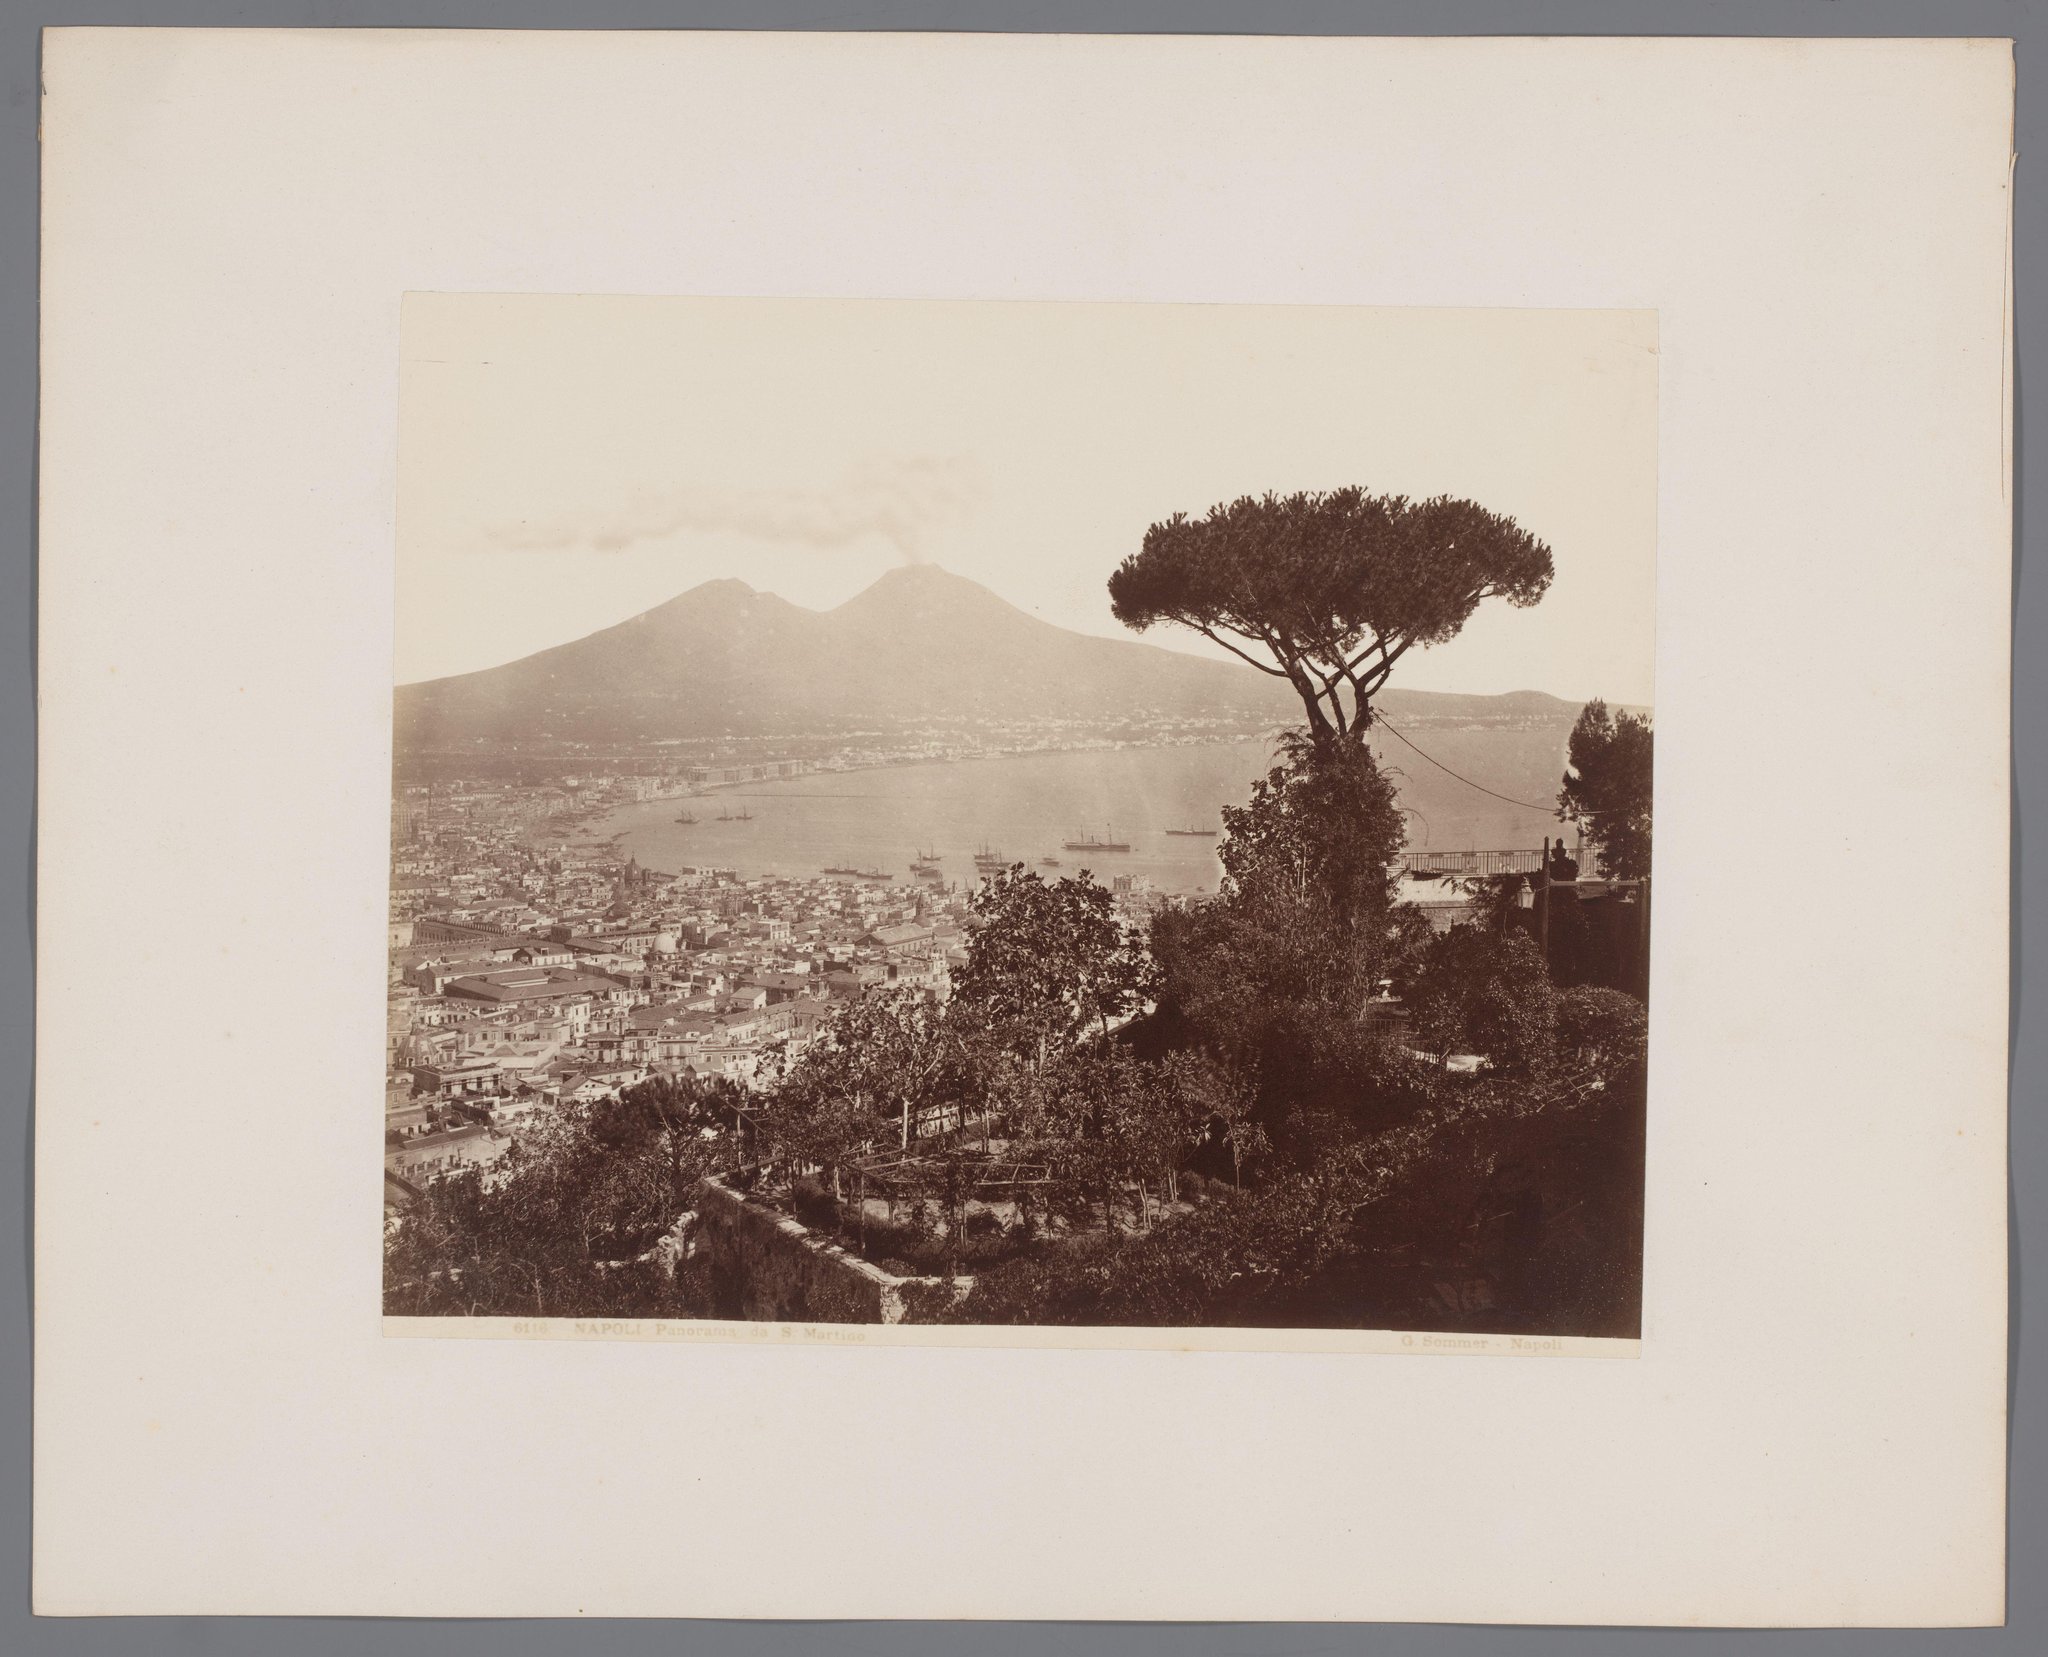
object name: photograph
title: Gezicht op Napels en de baai, Italië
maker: giorgio sommer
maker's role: fotograaf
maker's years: 1834-1914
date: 1867-1873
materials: cardboard, paper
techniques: albumen print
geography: naples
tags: gulf, bay, trees: pine, prospect of city, town panorama, silhouette of city, naples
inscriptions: number: ‘6116.’